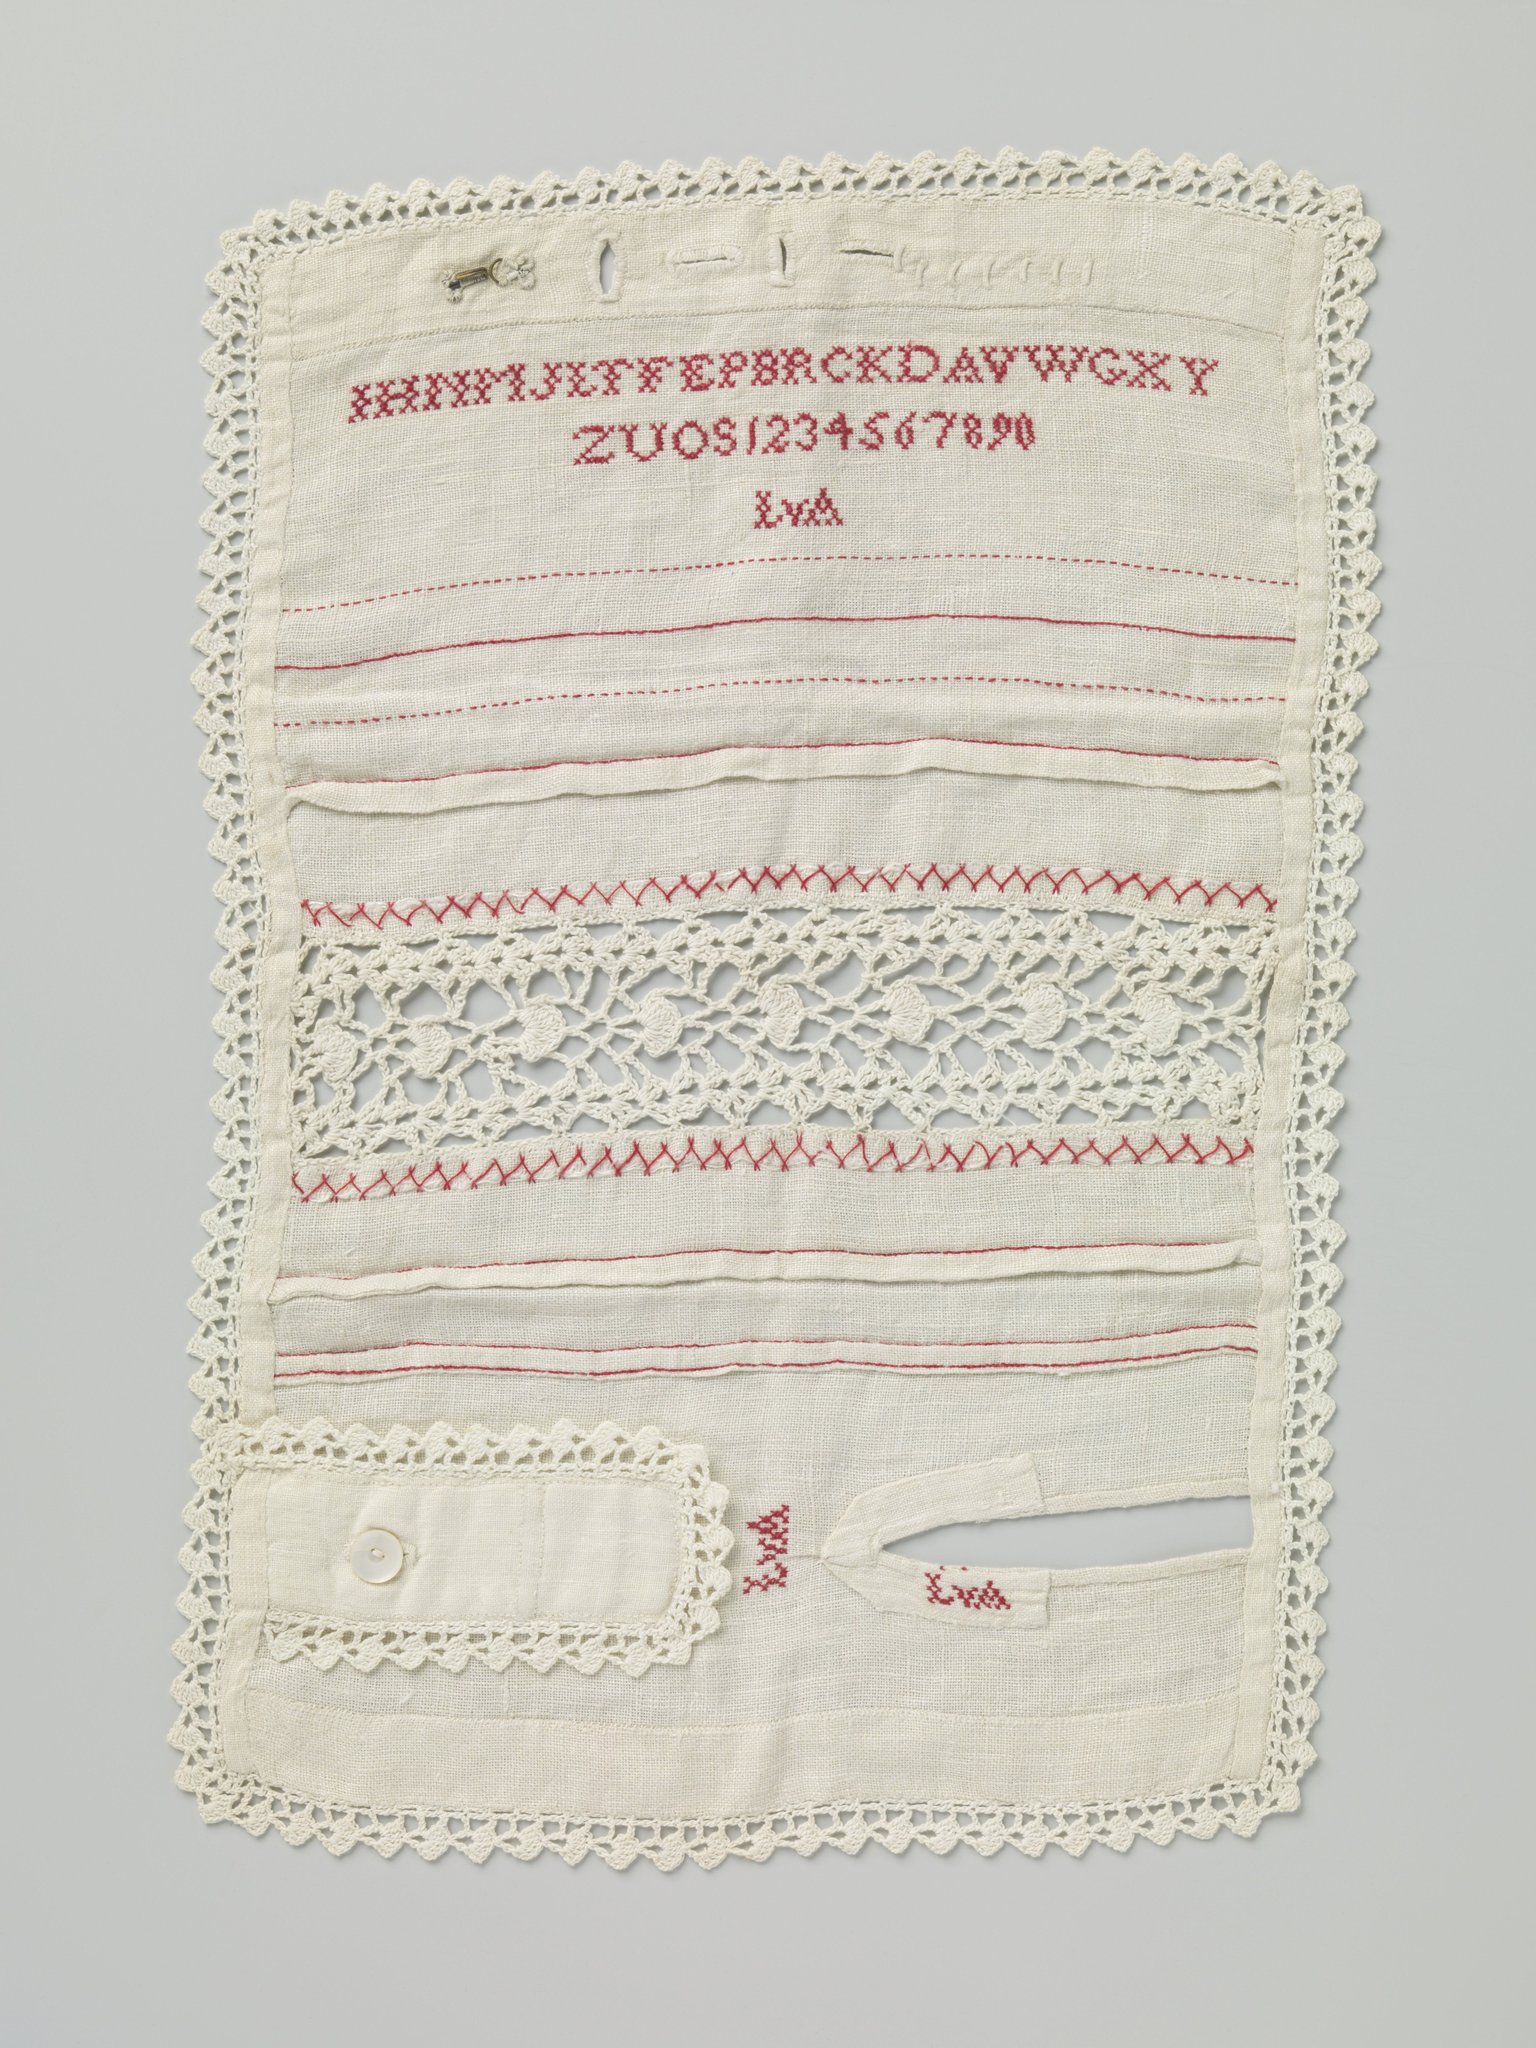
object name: naaiwerk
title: Naden- en stukkenlap van rode katoen op linnen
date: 1916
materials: cotton, linen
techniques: crochet, embroidered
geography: amsterdam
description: Naden- en stukkenlap van rode katoen op linnen. Het borduurwerk heeft een opbouwende letterreeks. De lap is afgezet met een linnen band en een geschulpte strook haakwerk.